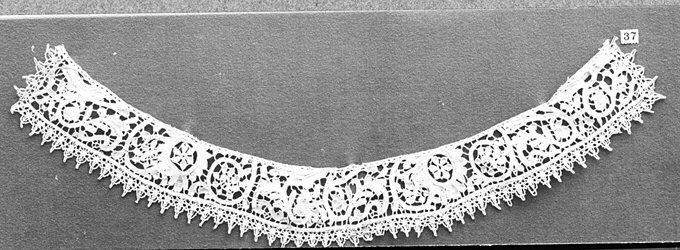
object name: collar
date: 1601-1700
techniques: lace